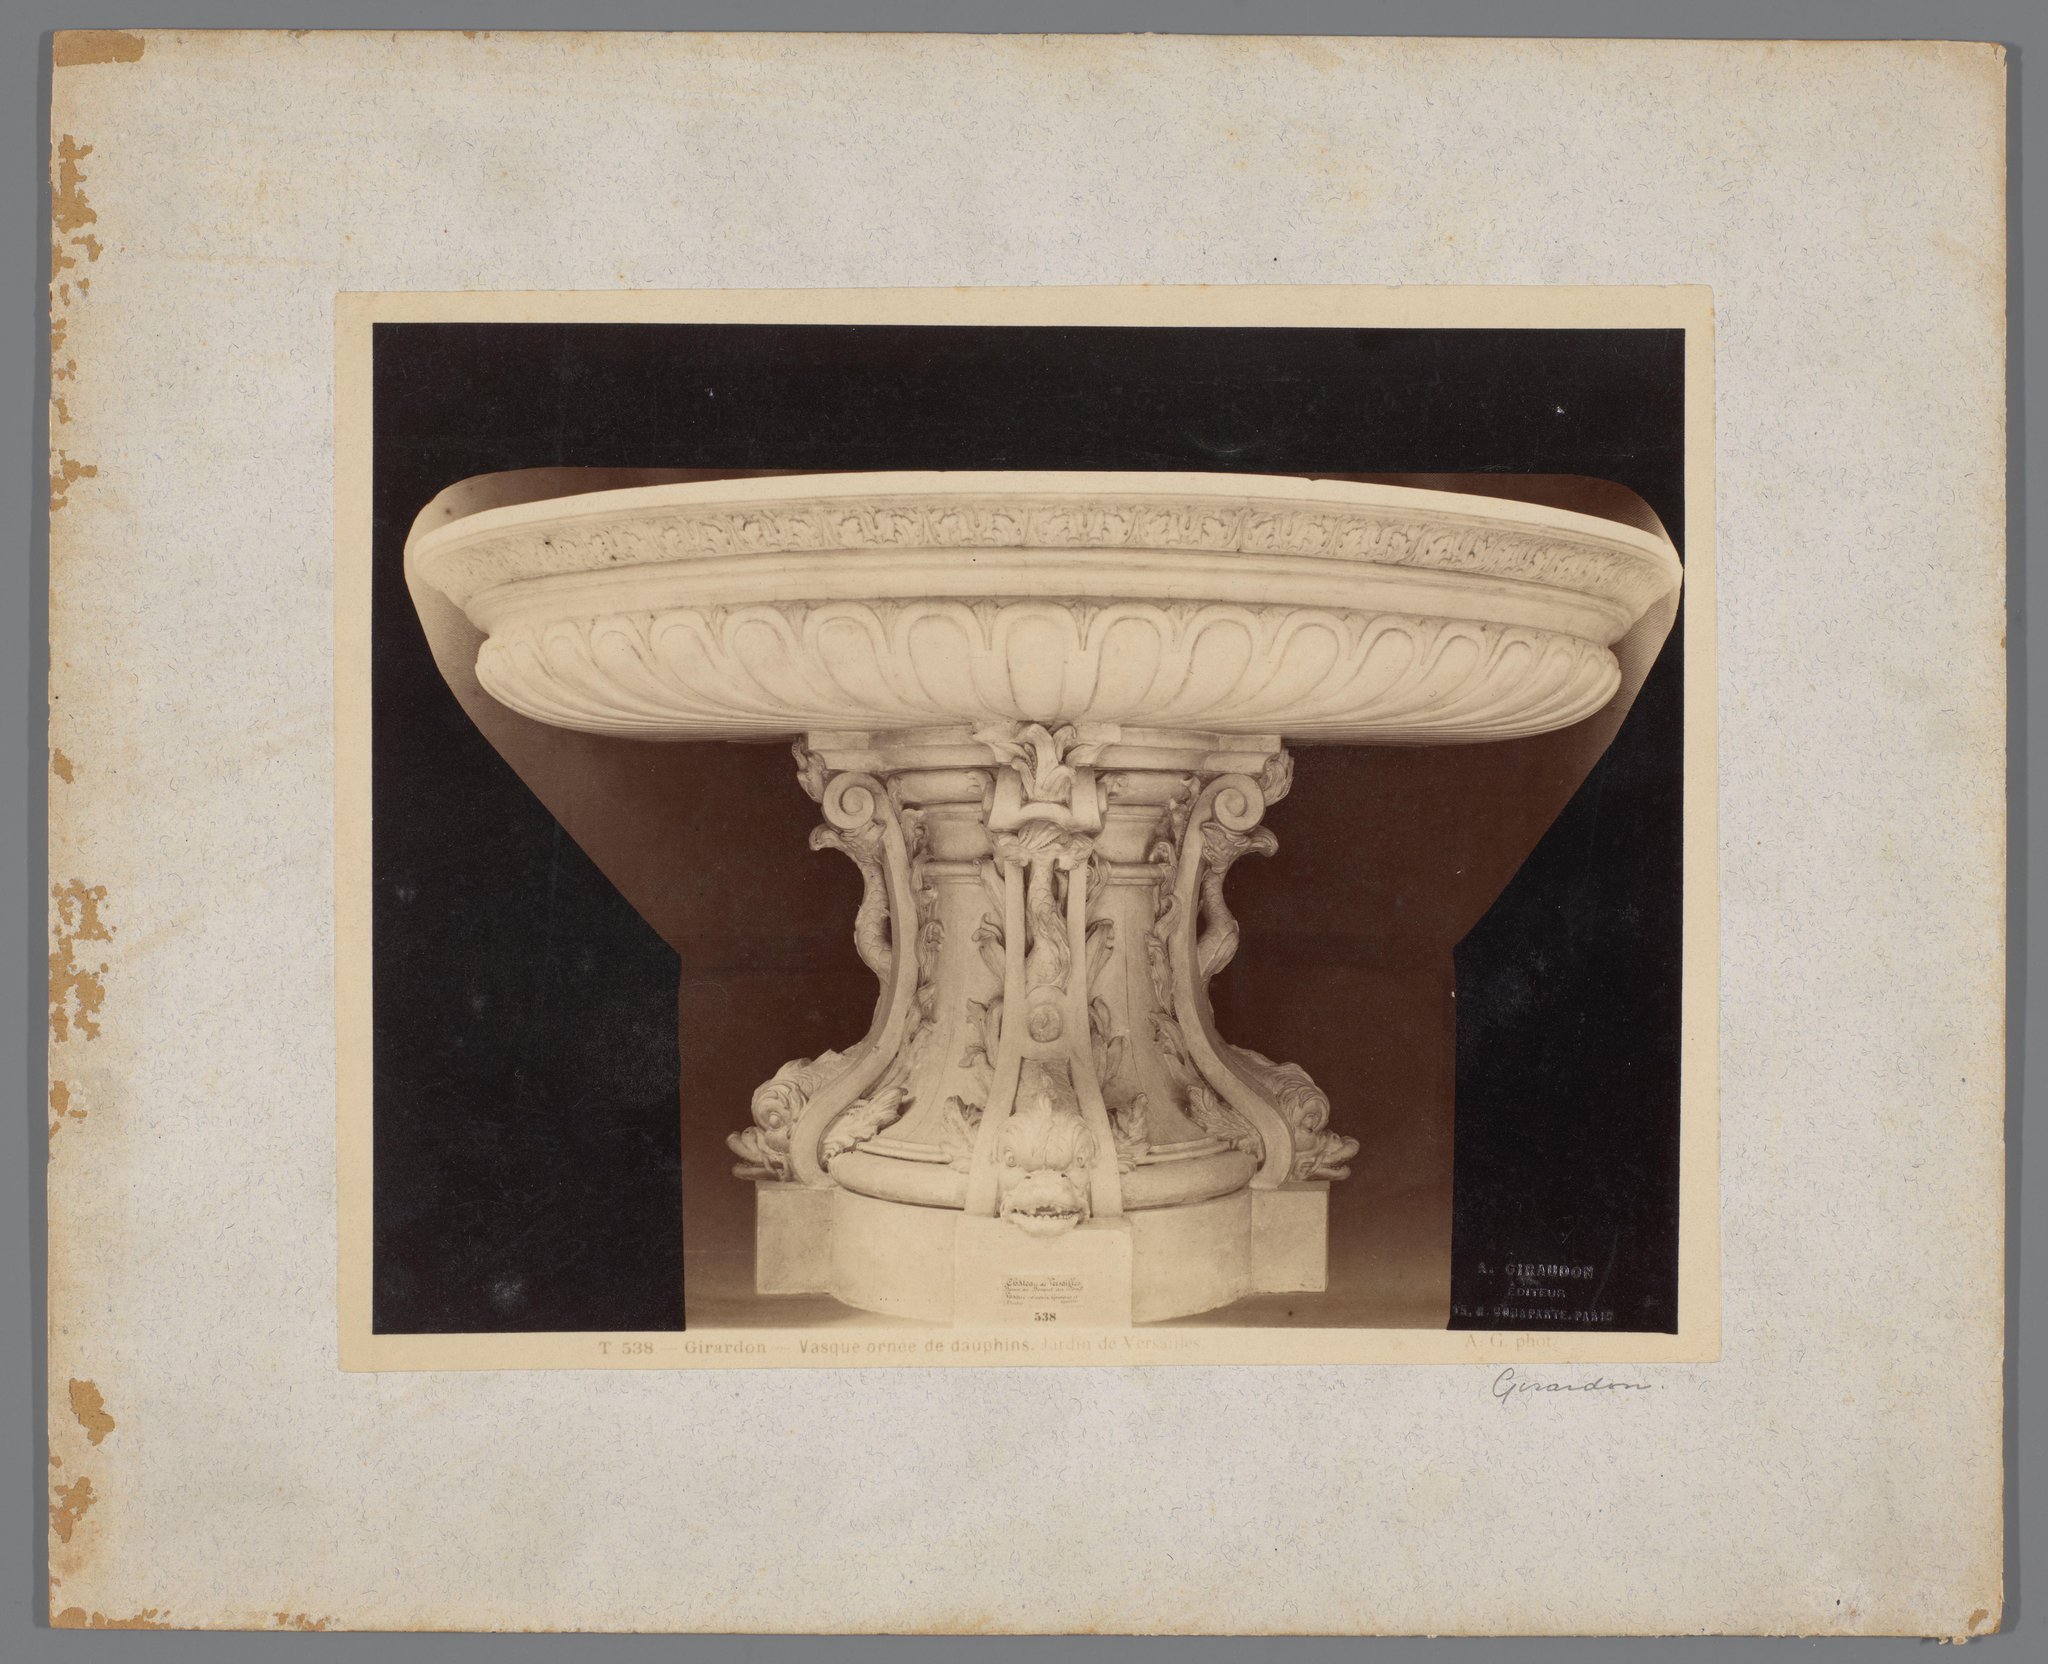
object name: photograph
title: Bekken gedecoreerd met dolfijnen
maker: adolphe giraudon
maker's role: publisher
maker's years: 1849-1929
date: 1850-1900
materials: cardboard, photographic support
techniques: albumen print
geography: paris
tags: sink, basin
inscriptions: collector's mark: ‘RIJKS-NORMAALSCHOOL voor TEEKENONDERWIJZERS. AMSTERDAM’, inscription: ‘A.G. phot.’, number: ‘T 538’, inscription: ‘Jardin de Versailles’, annotation: ‘Girardon’, workshop stamp: ‘A. Giraudon/ Éditeur/ 15. R. Bonaparte. Paris’